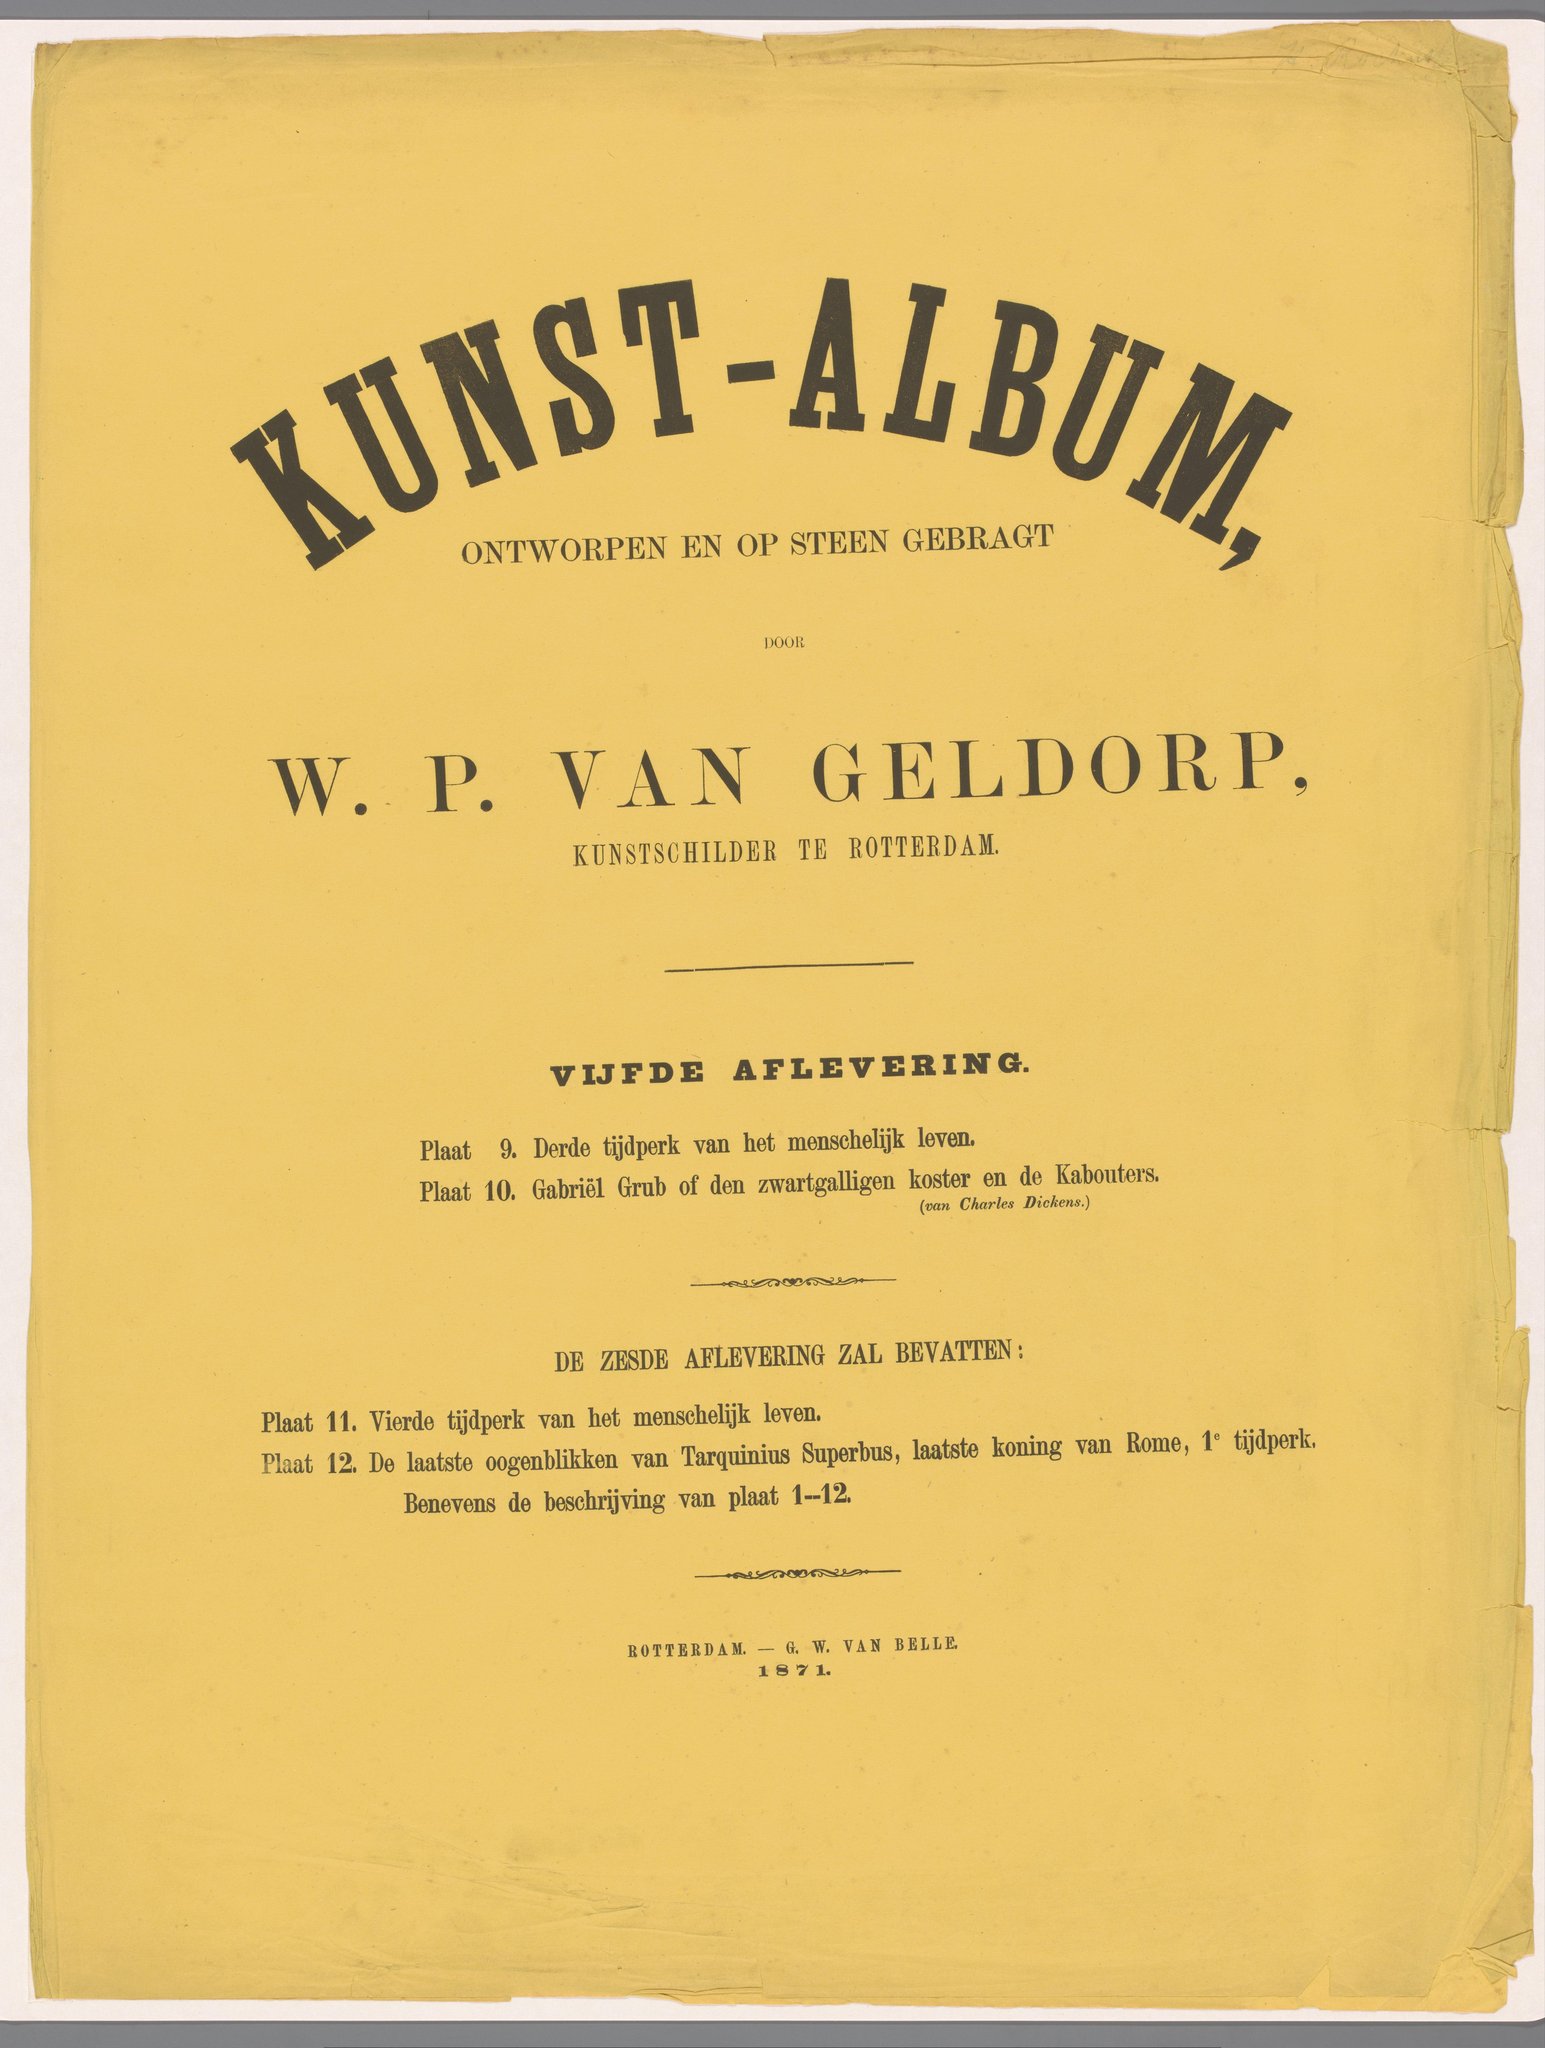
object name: print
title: Omslag voor Kunst-Album door W. P. van Geldorp vijfde aflevering 1871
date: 1871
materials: paper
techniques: lithograph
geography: rotterdam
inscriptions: date